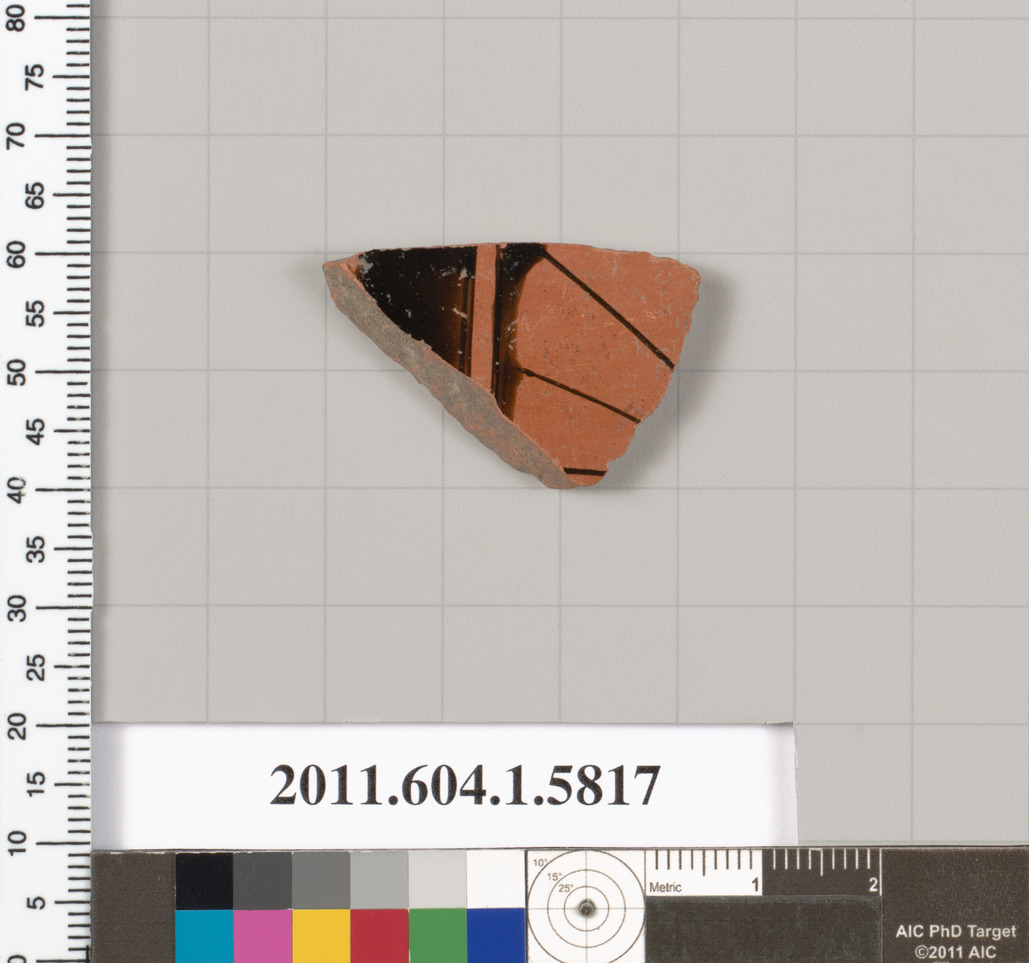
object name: kylix fragment, eye cup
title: Terracotta fragment of a kylix: eye-cup (drinking cup)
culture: greek, attic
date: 520-510 BCE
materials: terracotta